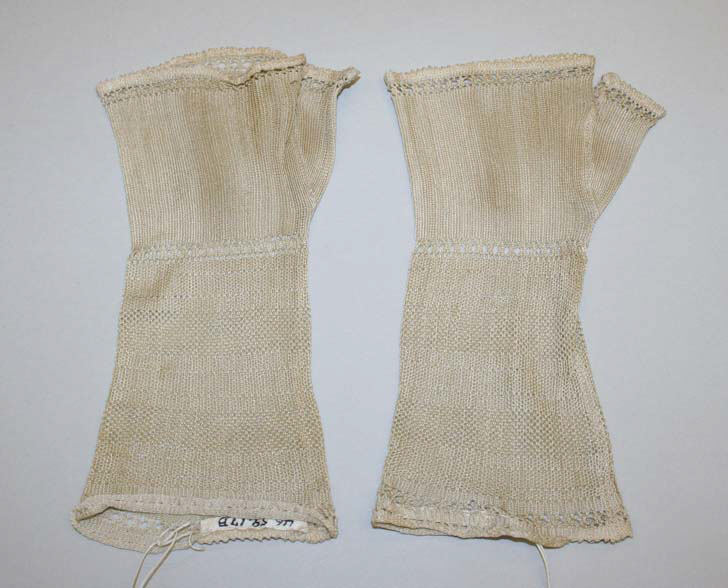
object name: mitt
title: Mitts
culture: french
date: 1820-1829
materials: silk